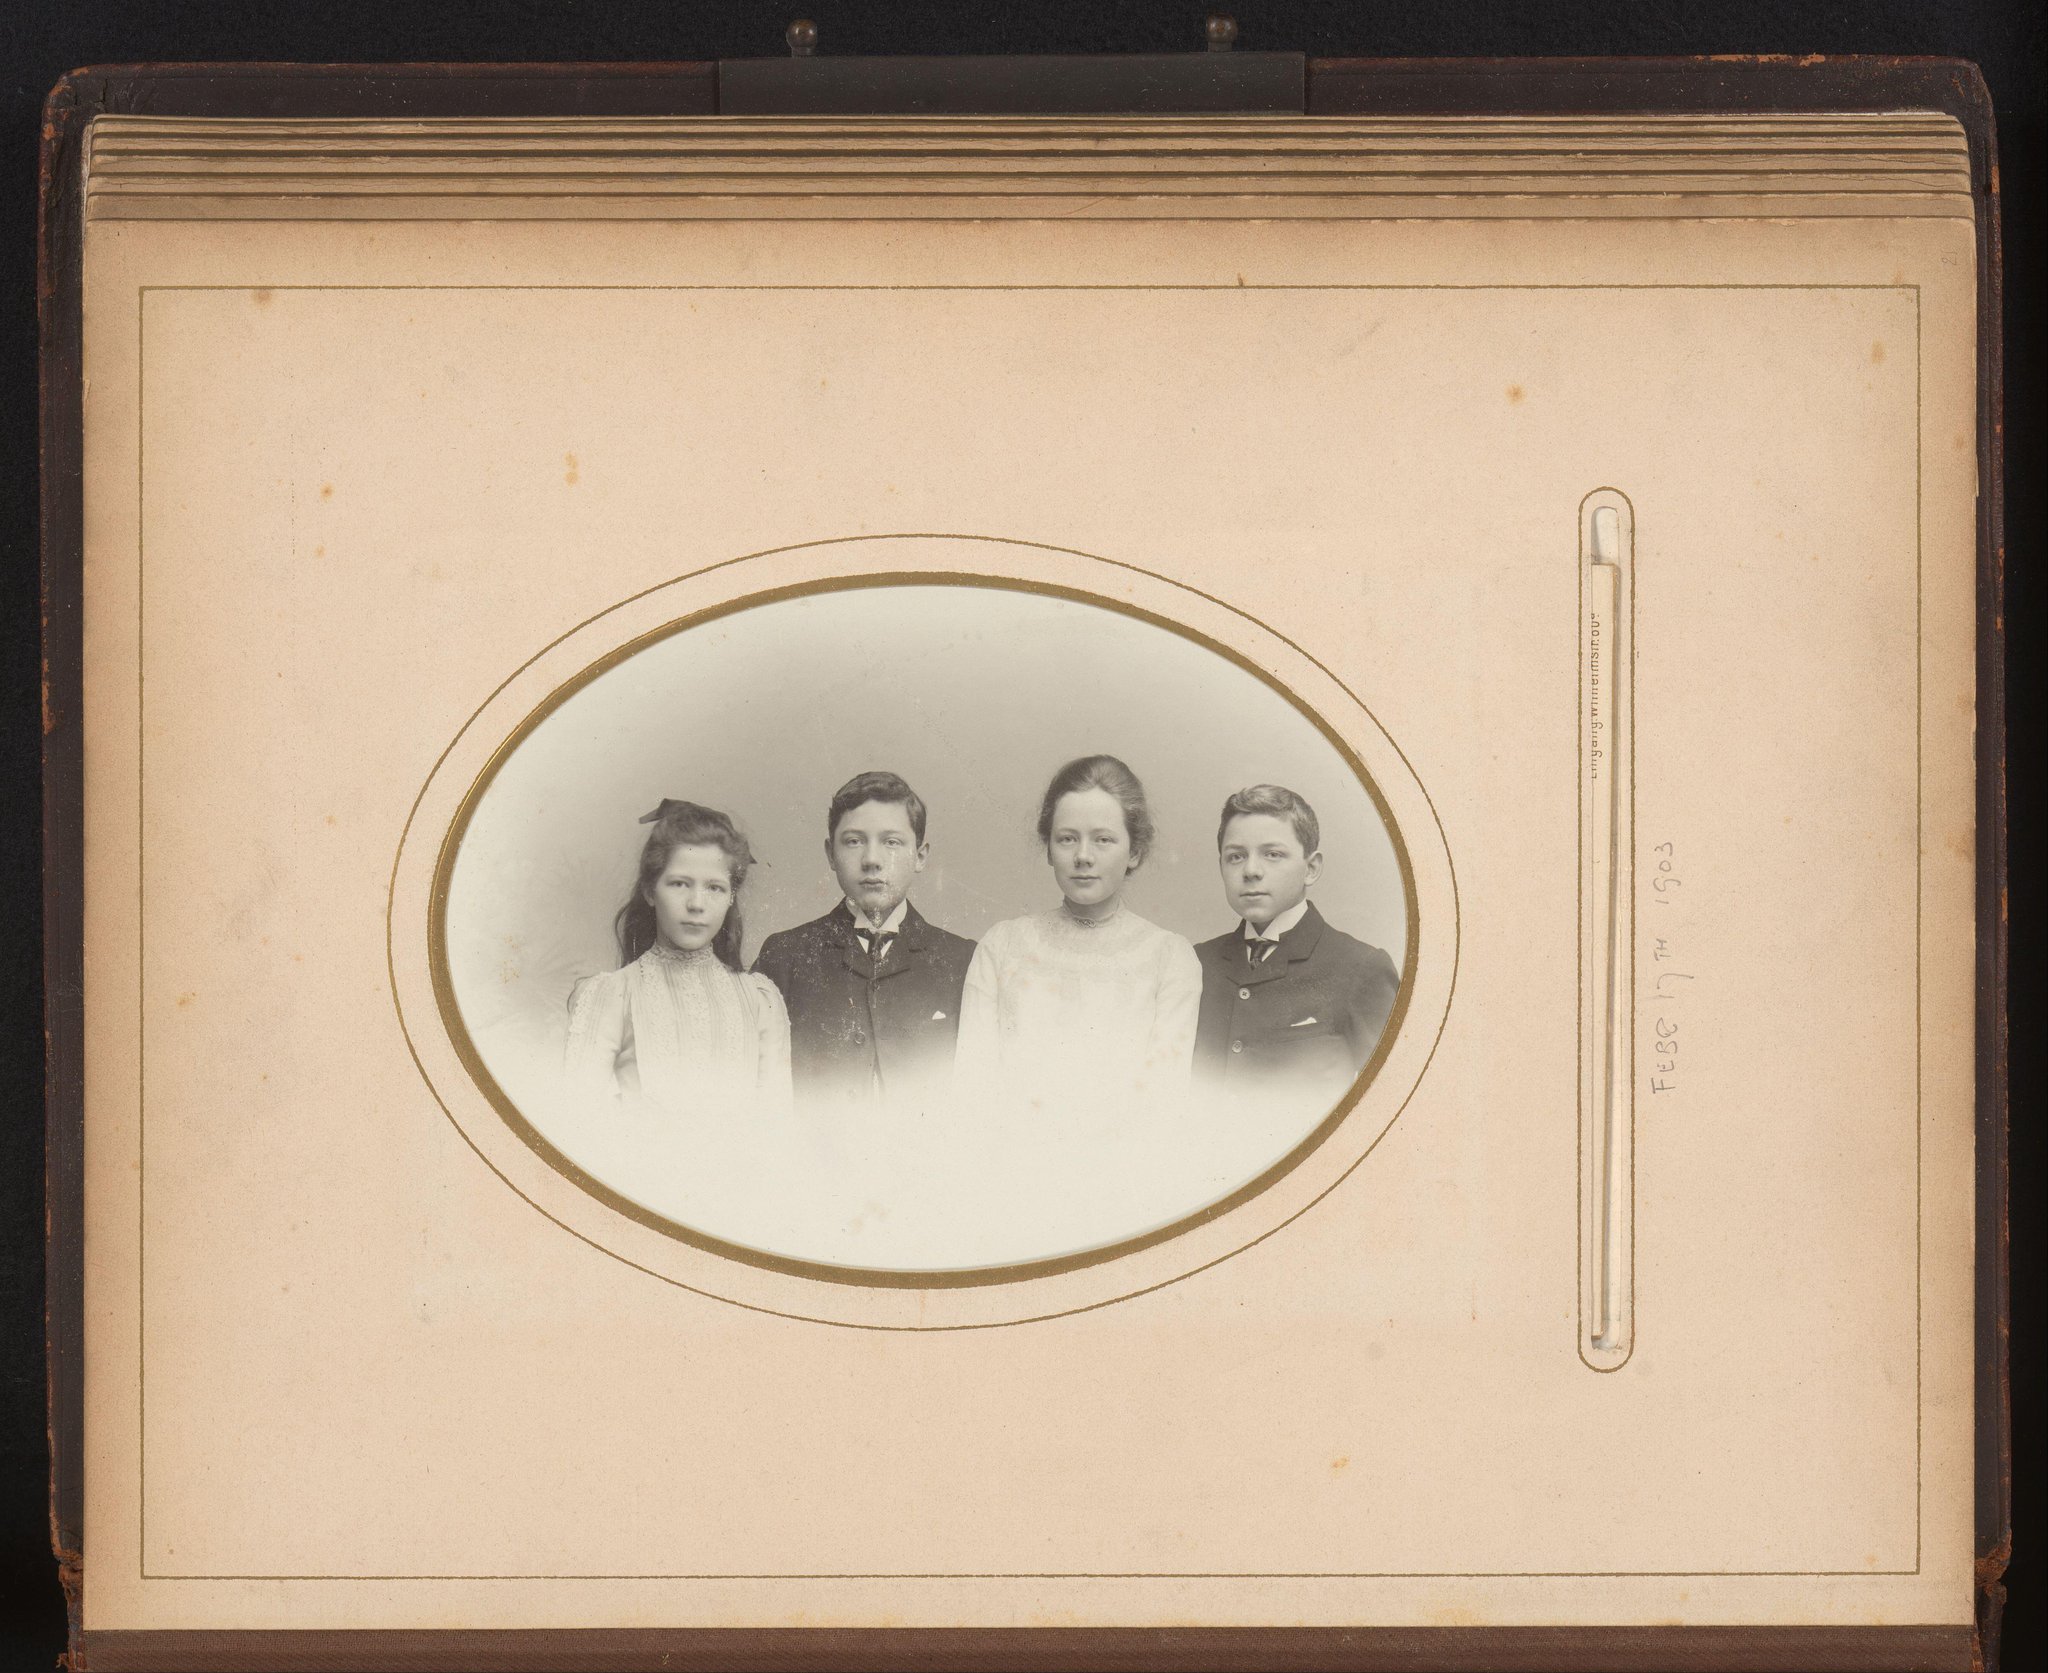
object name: cabinet photograph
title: Portret van Jessie, Tom, Dulcie en Willie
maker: fritz wernicke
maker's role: fotograaf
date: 1903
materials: cardboard, photographic support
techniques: collodion silver print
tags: child, anonymous historical persons portrayed in a group, in a group-portrait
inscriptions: inscription: ‘Fritz Wernicke/ Phottogr. art. Atelier/ Berlin W./ Leipzigerstr. 124/ (...)’, annotation: ‘Jessie/ Tom/ Duclie/ Willie/ Feb `17th 1903’